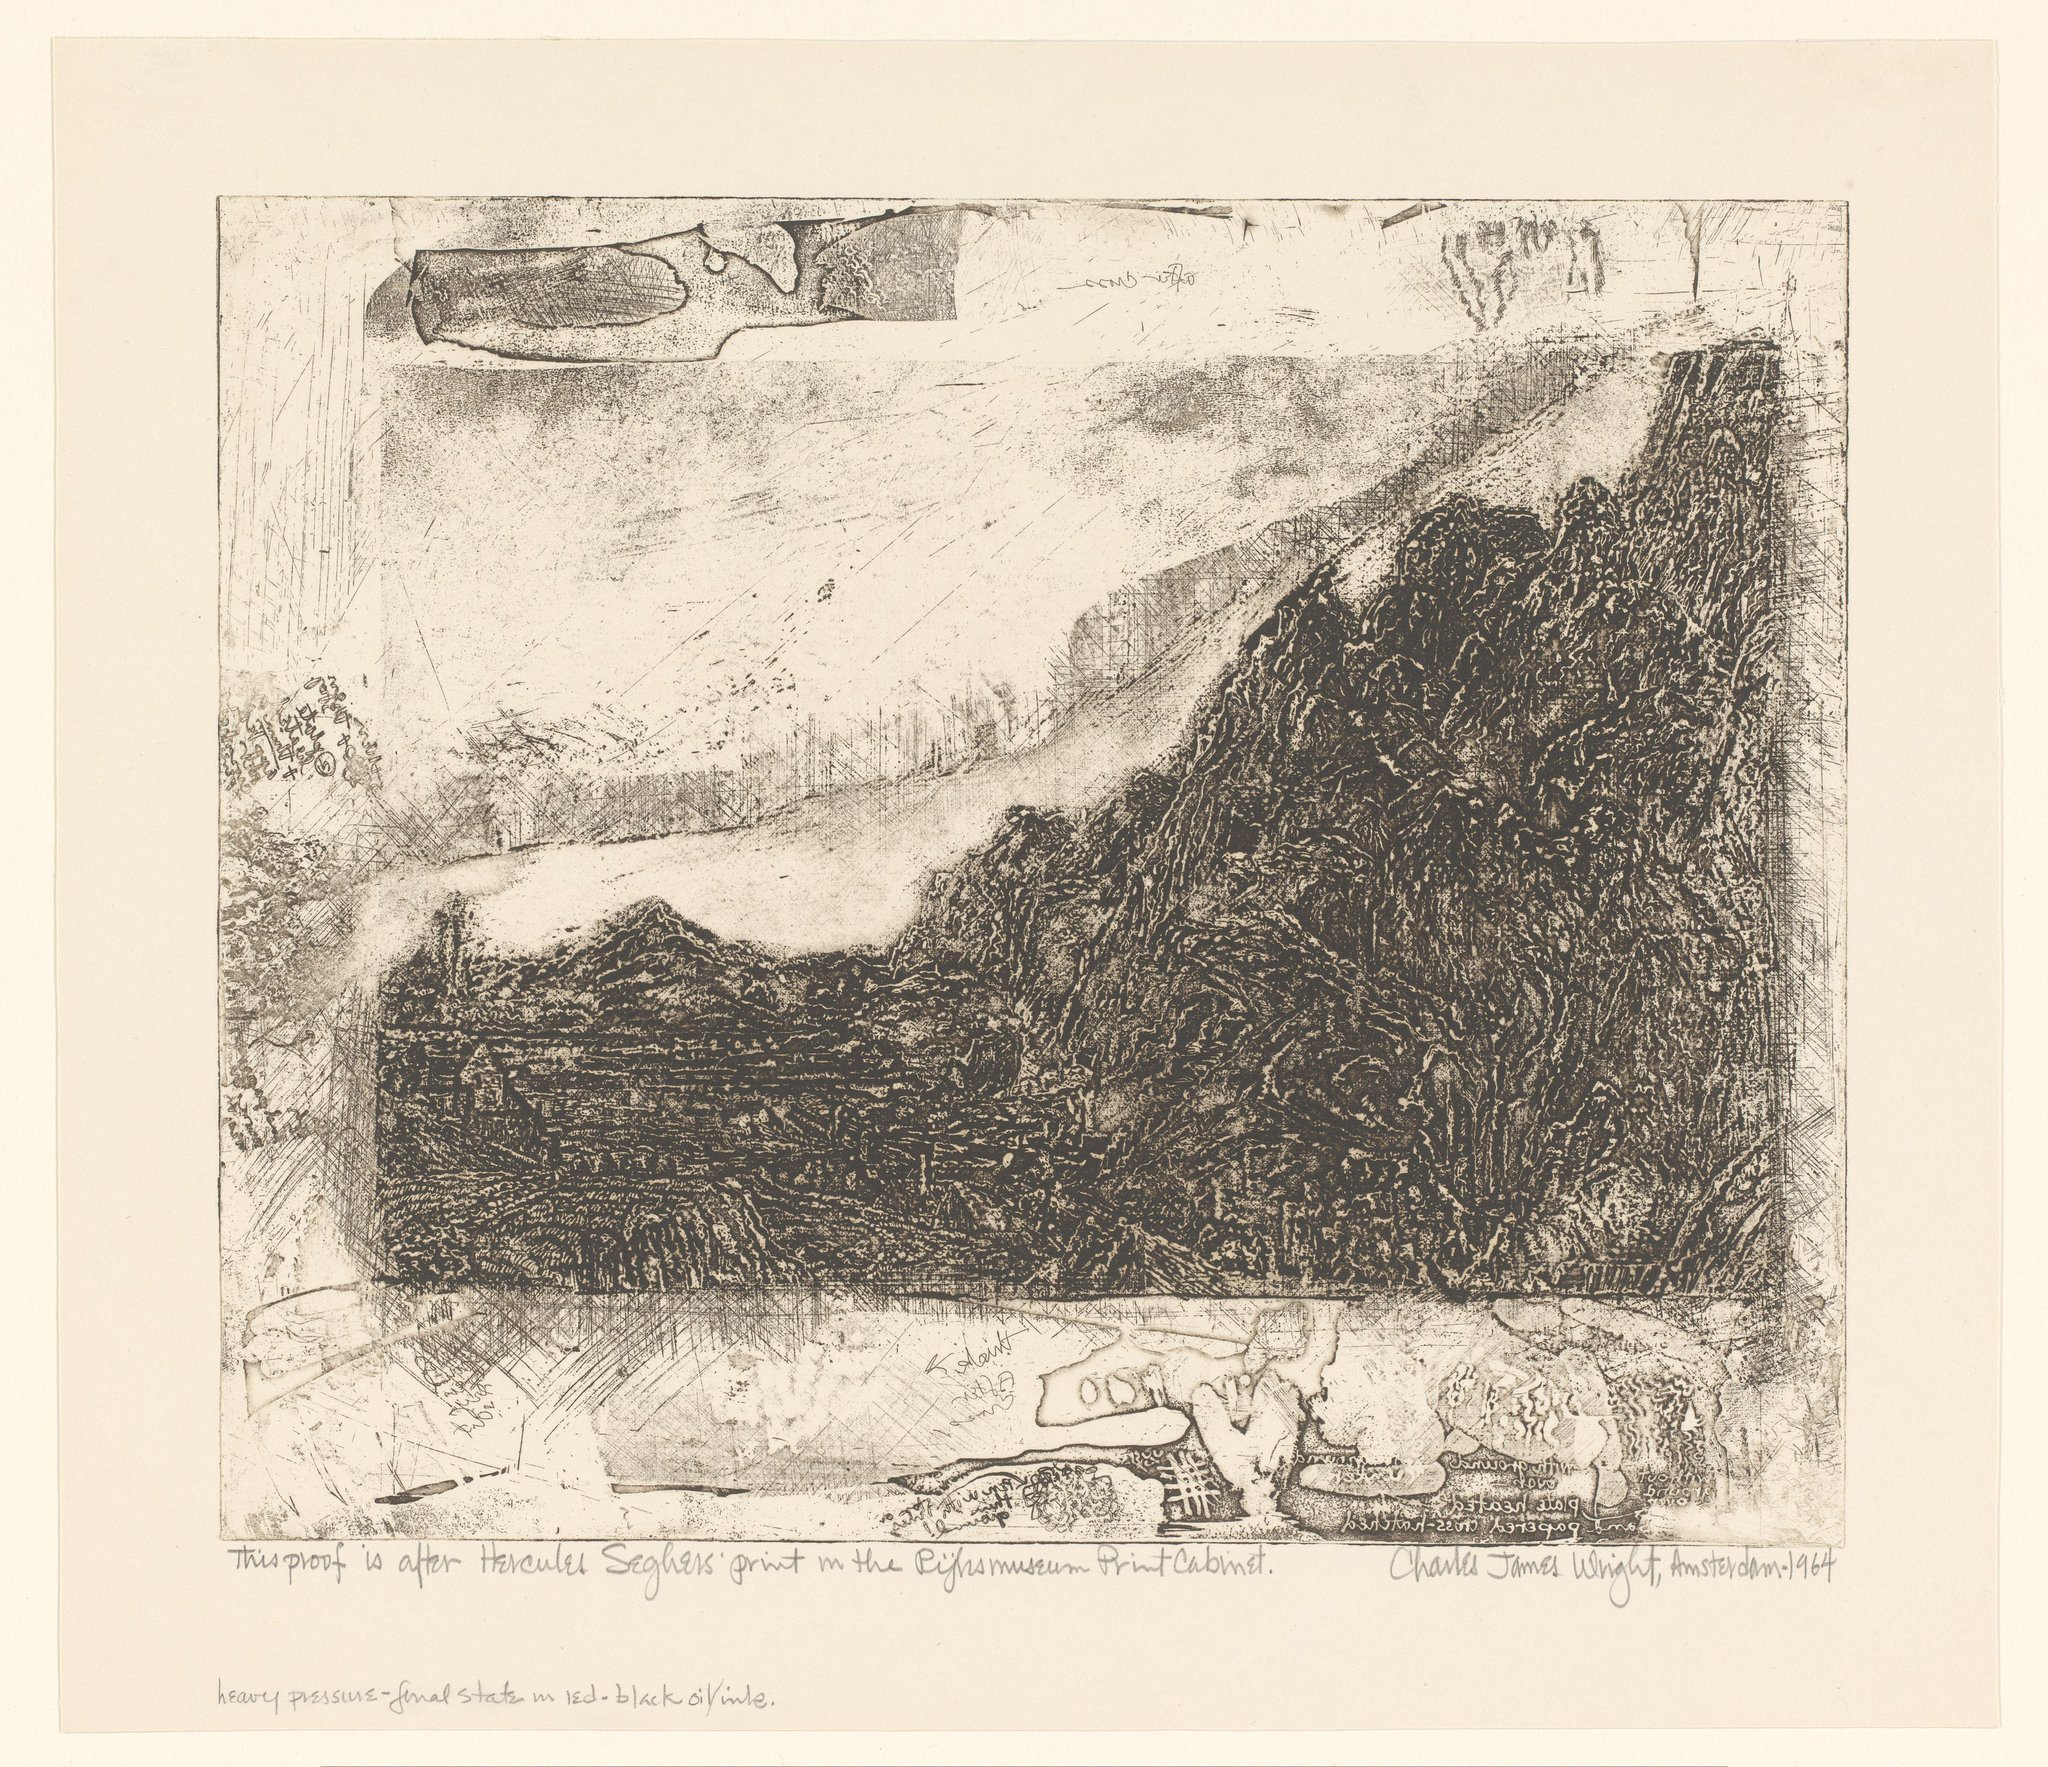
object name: print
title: Rotsachtig landschap met wegen en een rivier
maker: charles james wright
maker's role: artist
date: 1964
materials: paper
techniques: drypoint, etching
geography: amsterdam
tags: river, rocks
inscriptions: annotation: ‘heavy pressure - final state in led-black oil/ink.’, annotation: ‘This proof is after Hercules Seghers'print in the Rijksmuseum Print Cabinet.’, collector's mark: Lugt 2228, signature: ‘Charles James Wright, Amsterdam - 1964’, annotation: ‘heavy pressure - final state in led-black oil/ink’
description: In de collectie bevinden zich vier proeven in de techniek van Hercules Segers van de hand van Wright.